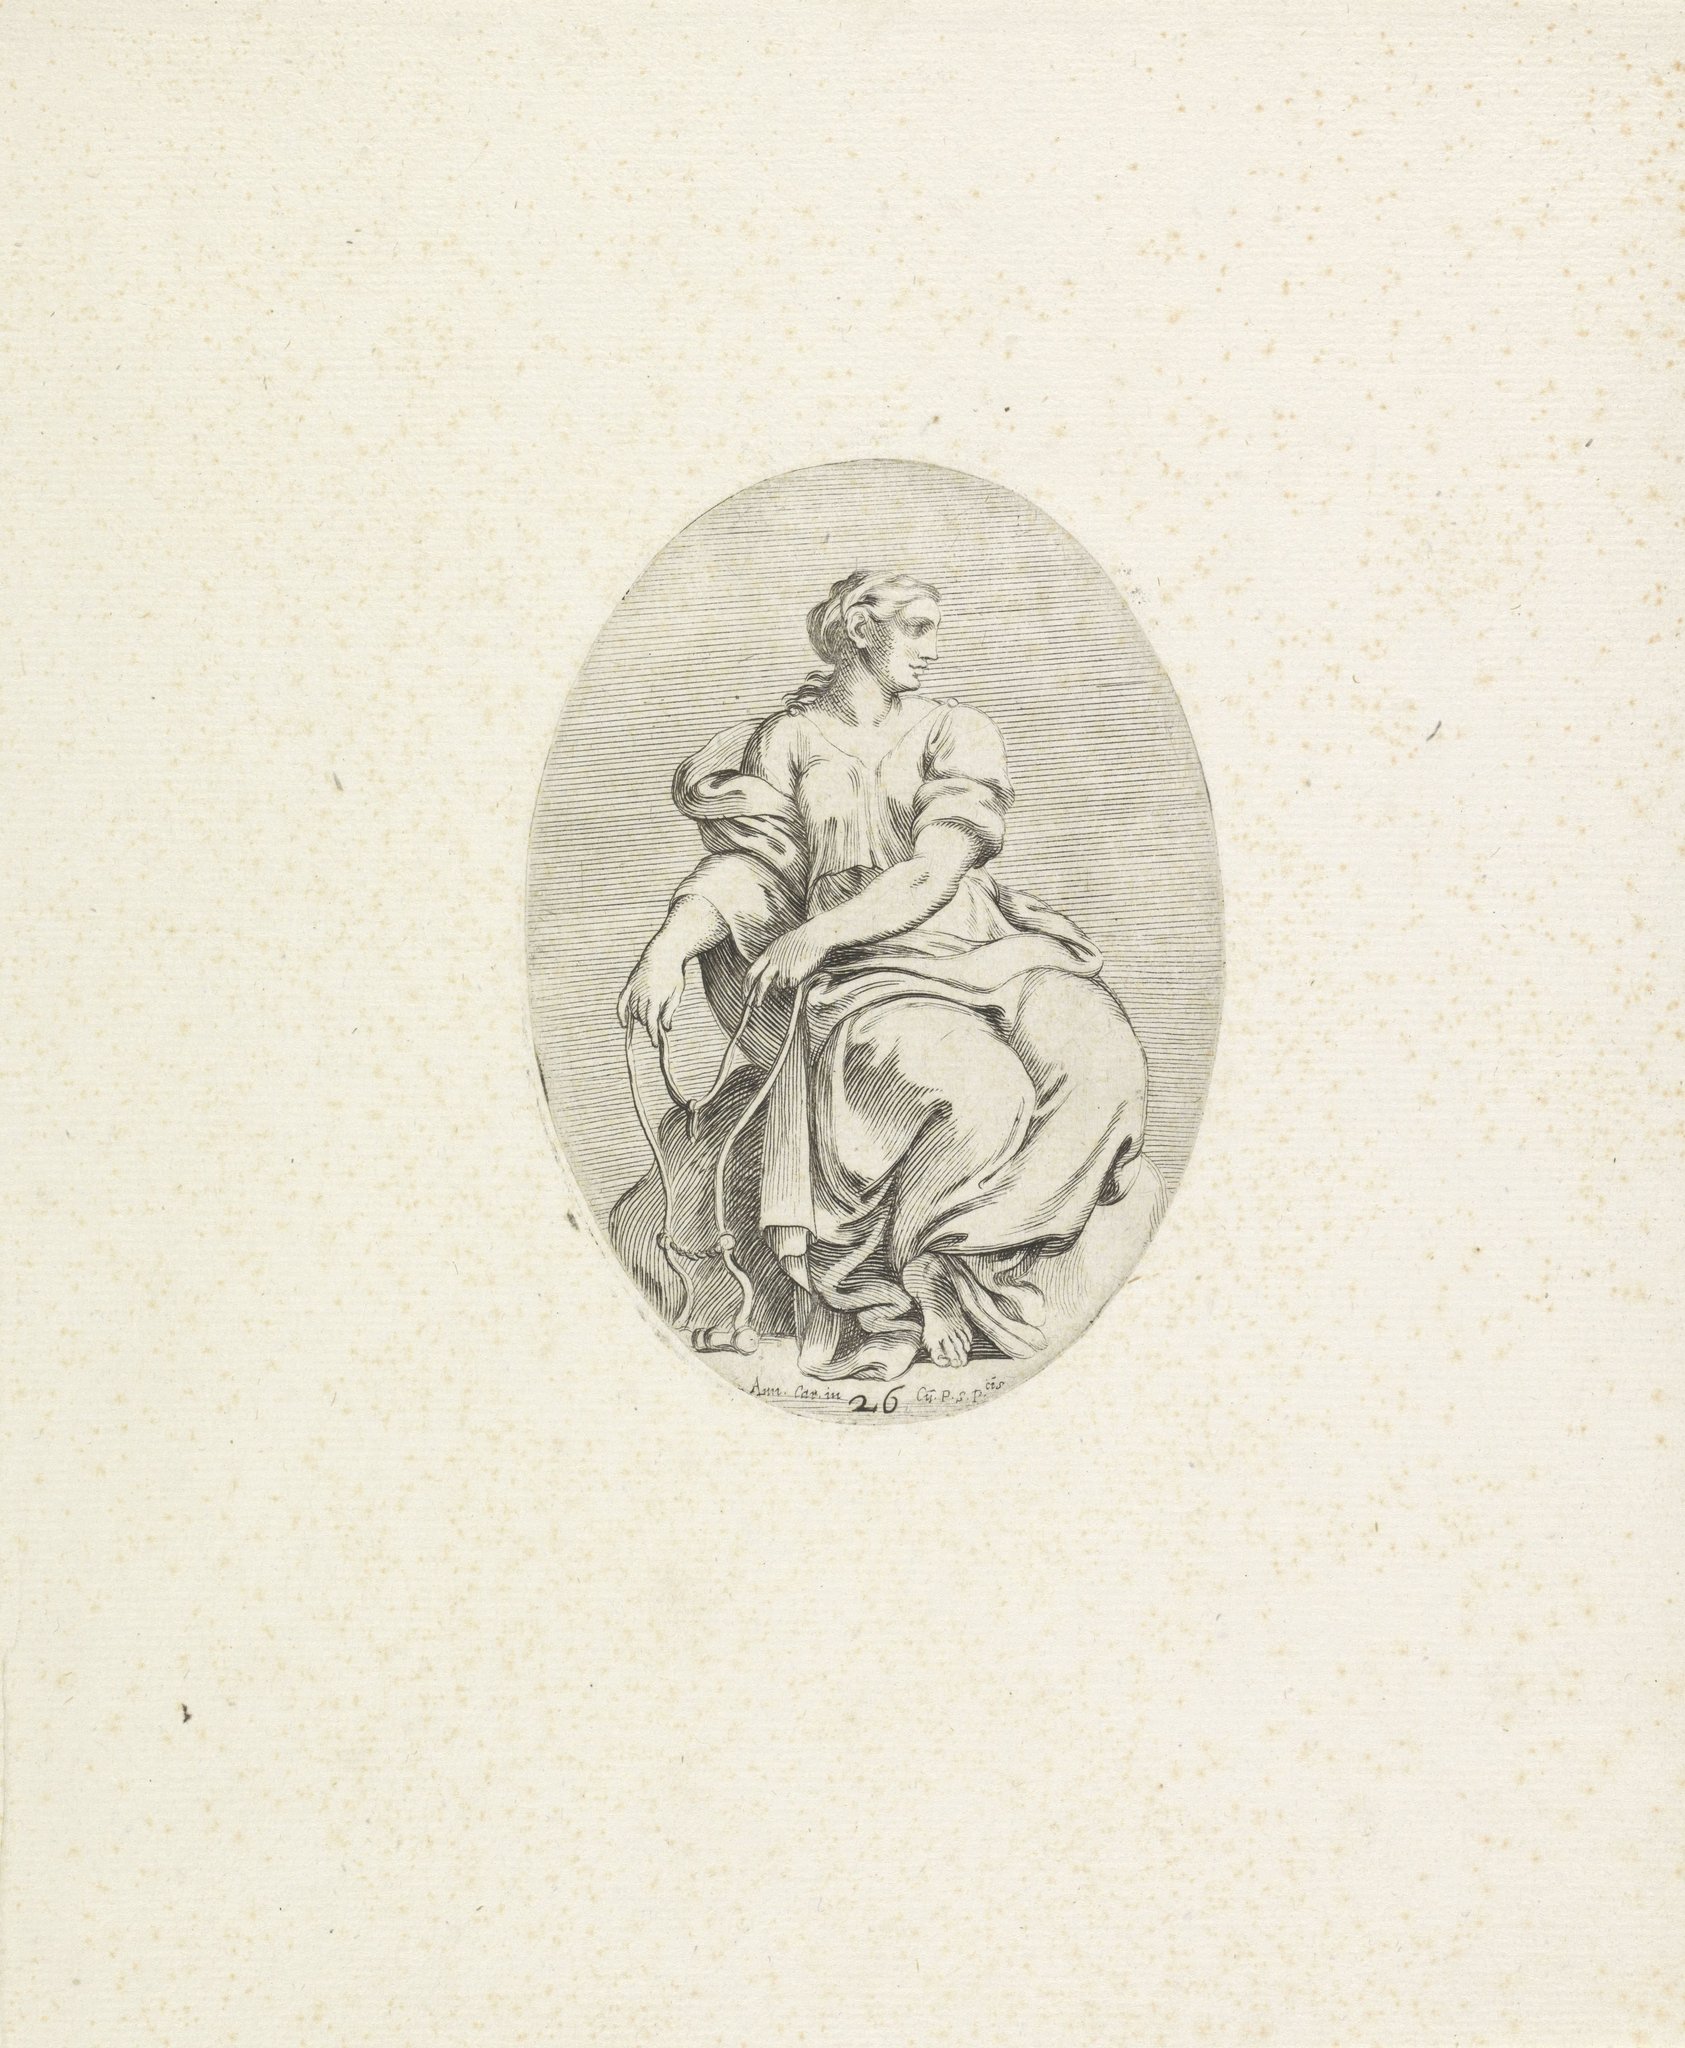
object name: print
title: Matigheid (Temperantia)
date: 1656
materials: paper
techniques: etching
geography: rome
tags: temperance, moderation; 'misura' (ripa)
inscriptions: collector's mark: Lugt 2228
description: Prent uit een reeks prenten met nummers van 1 tot en met 29 (sommige prenten hebben hetzelfde nummer), plus titelprent en opdracht, naar schilderingen in Palazzo Farnese te Rome.